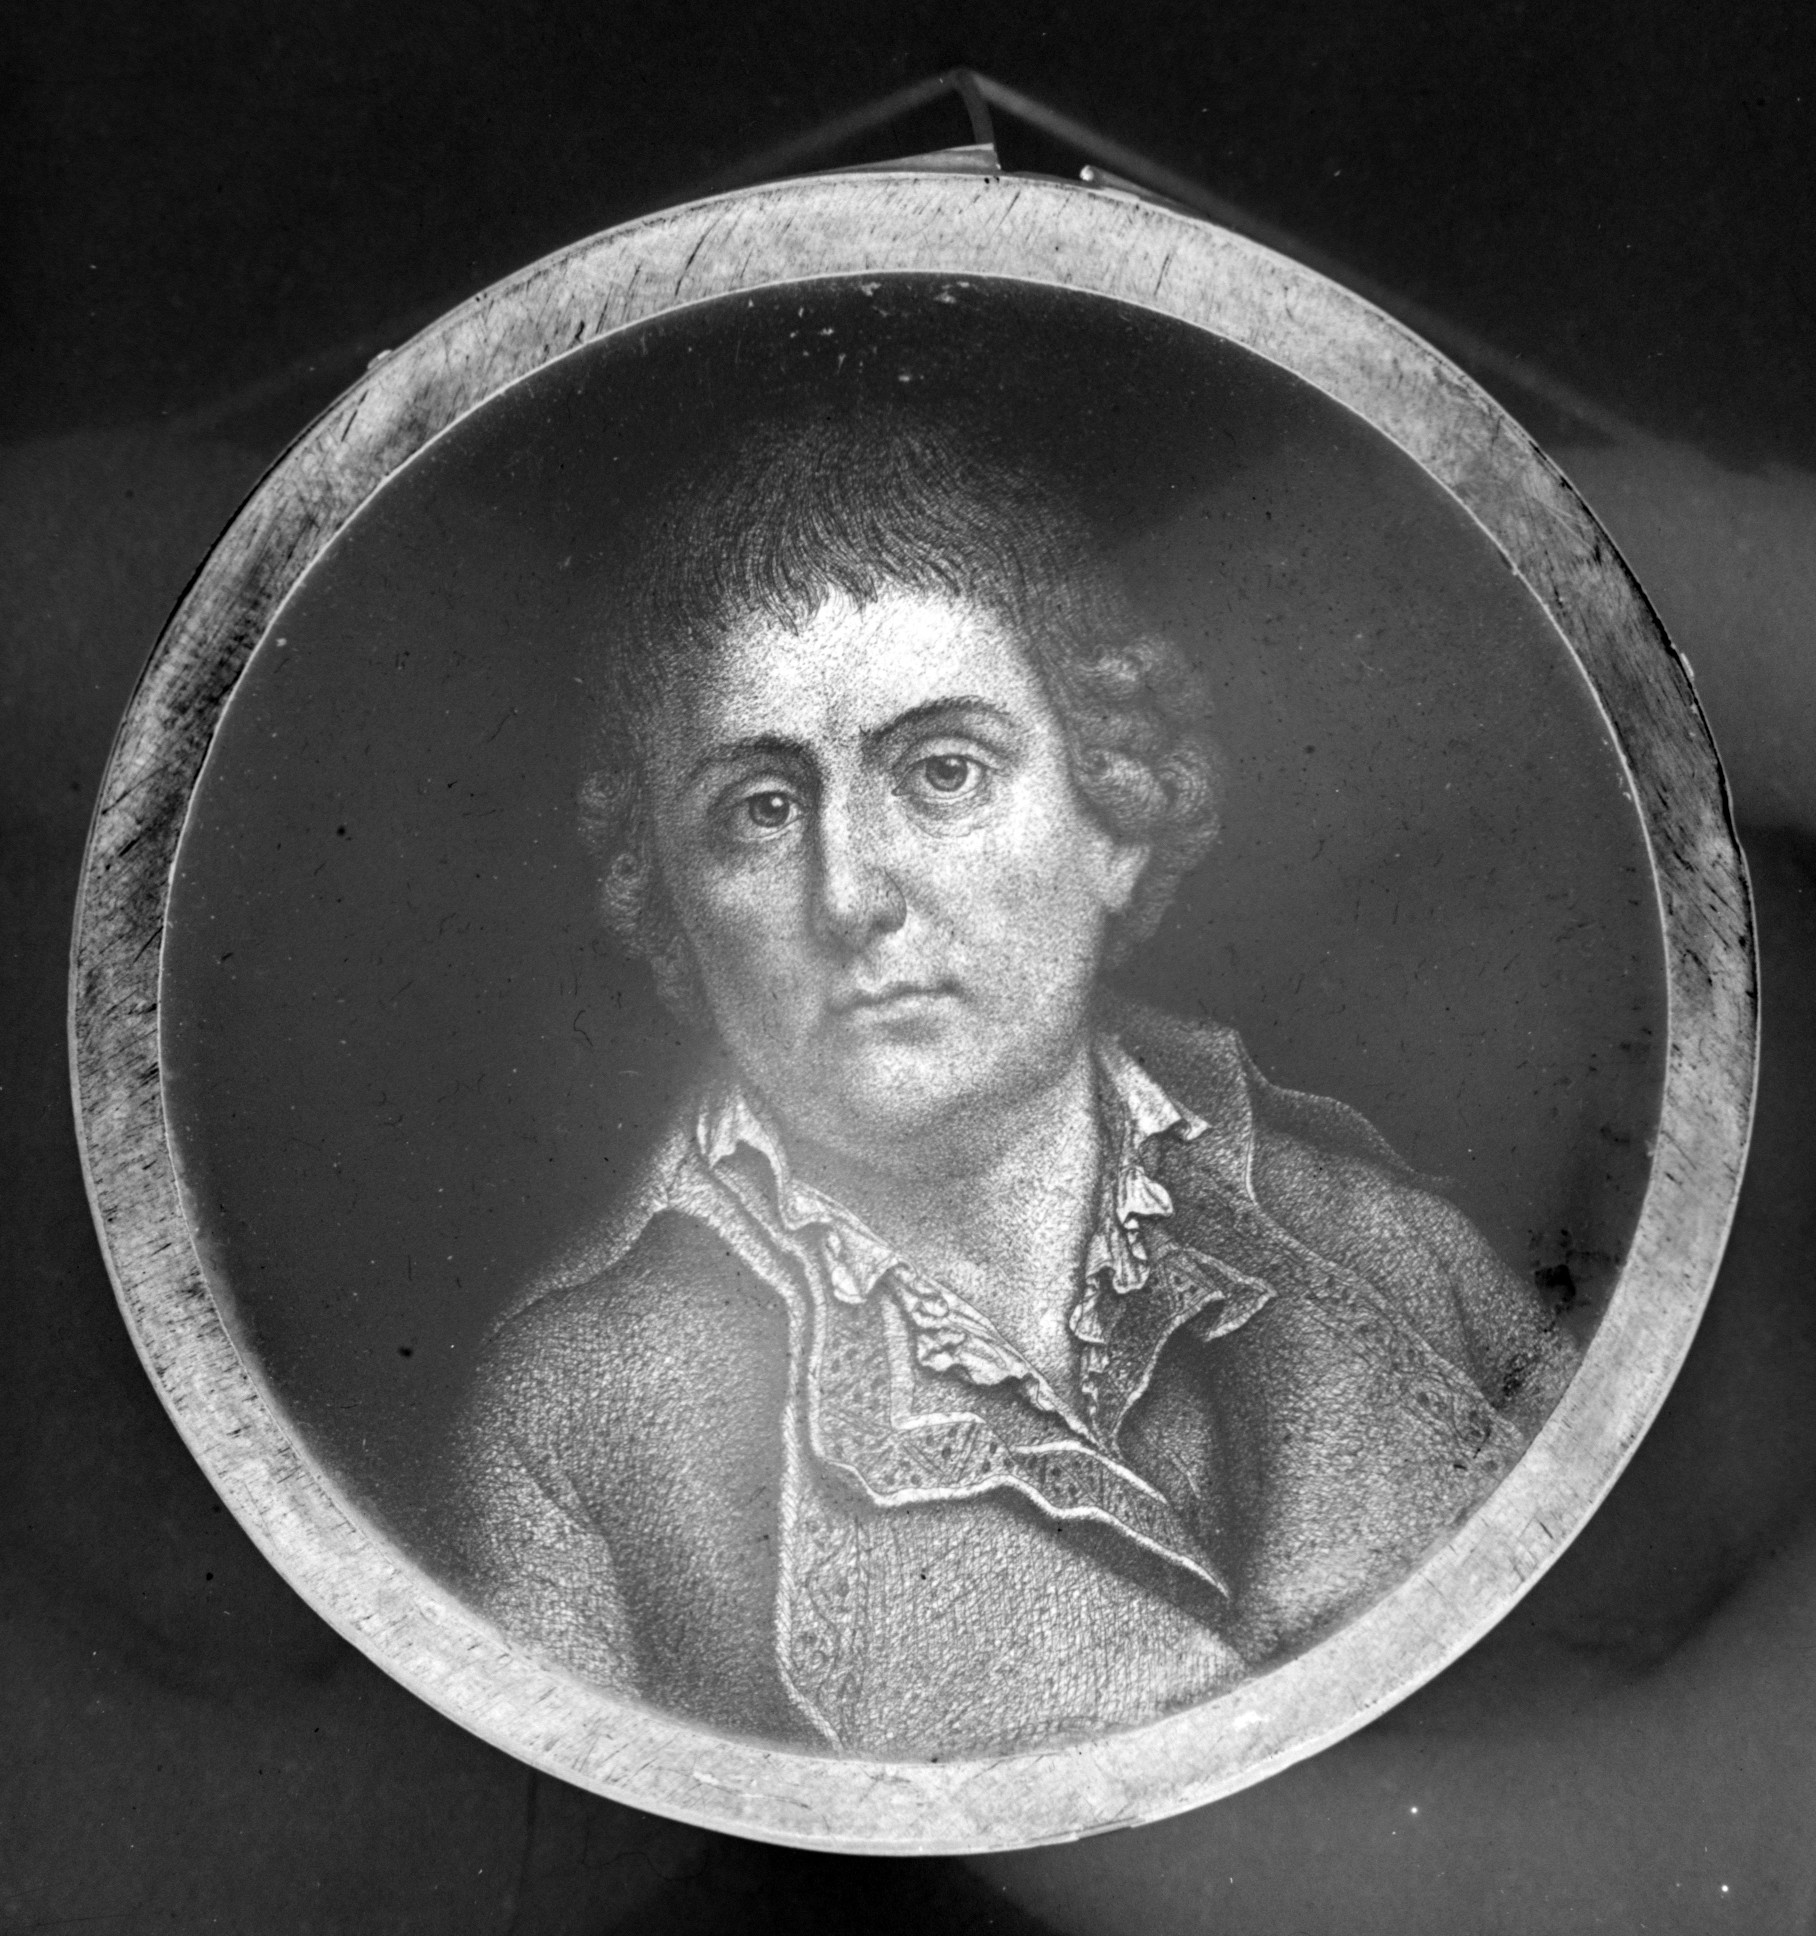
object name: medallion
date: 1767-1800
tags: men,portraits